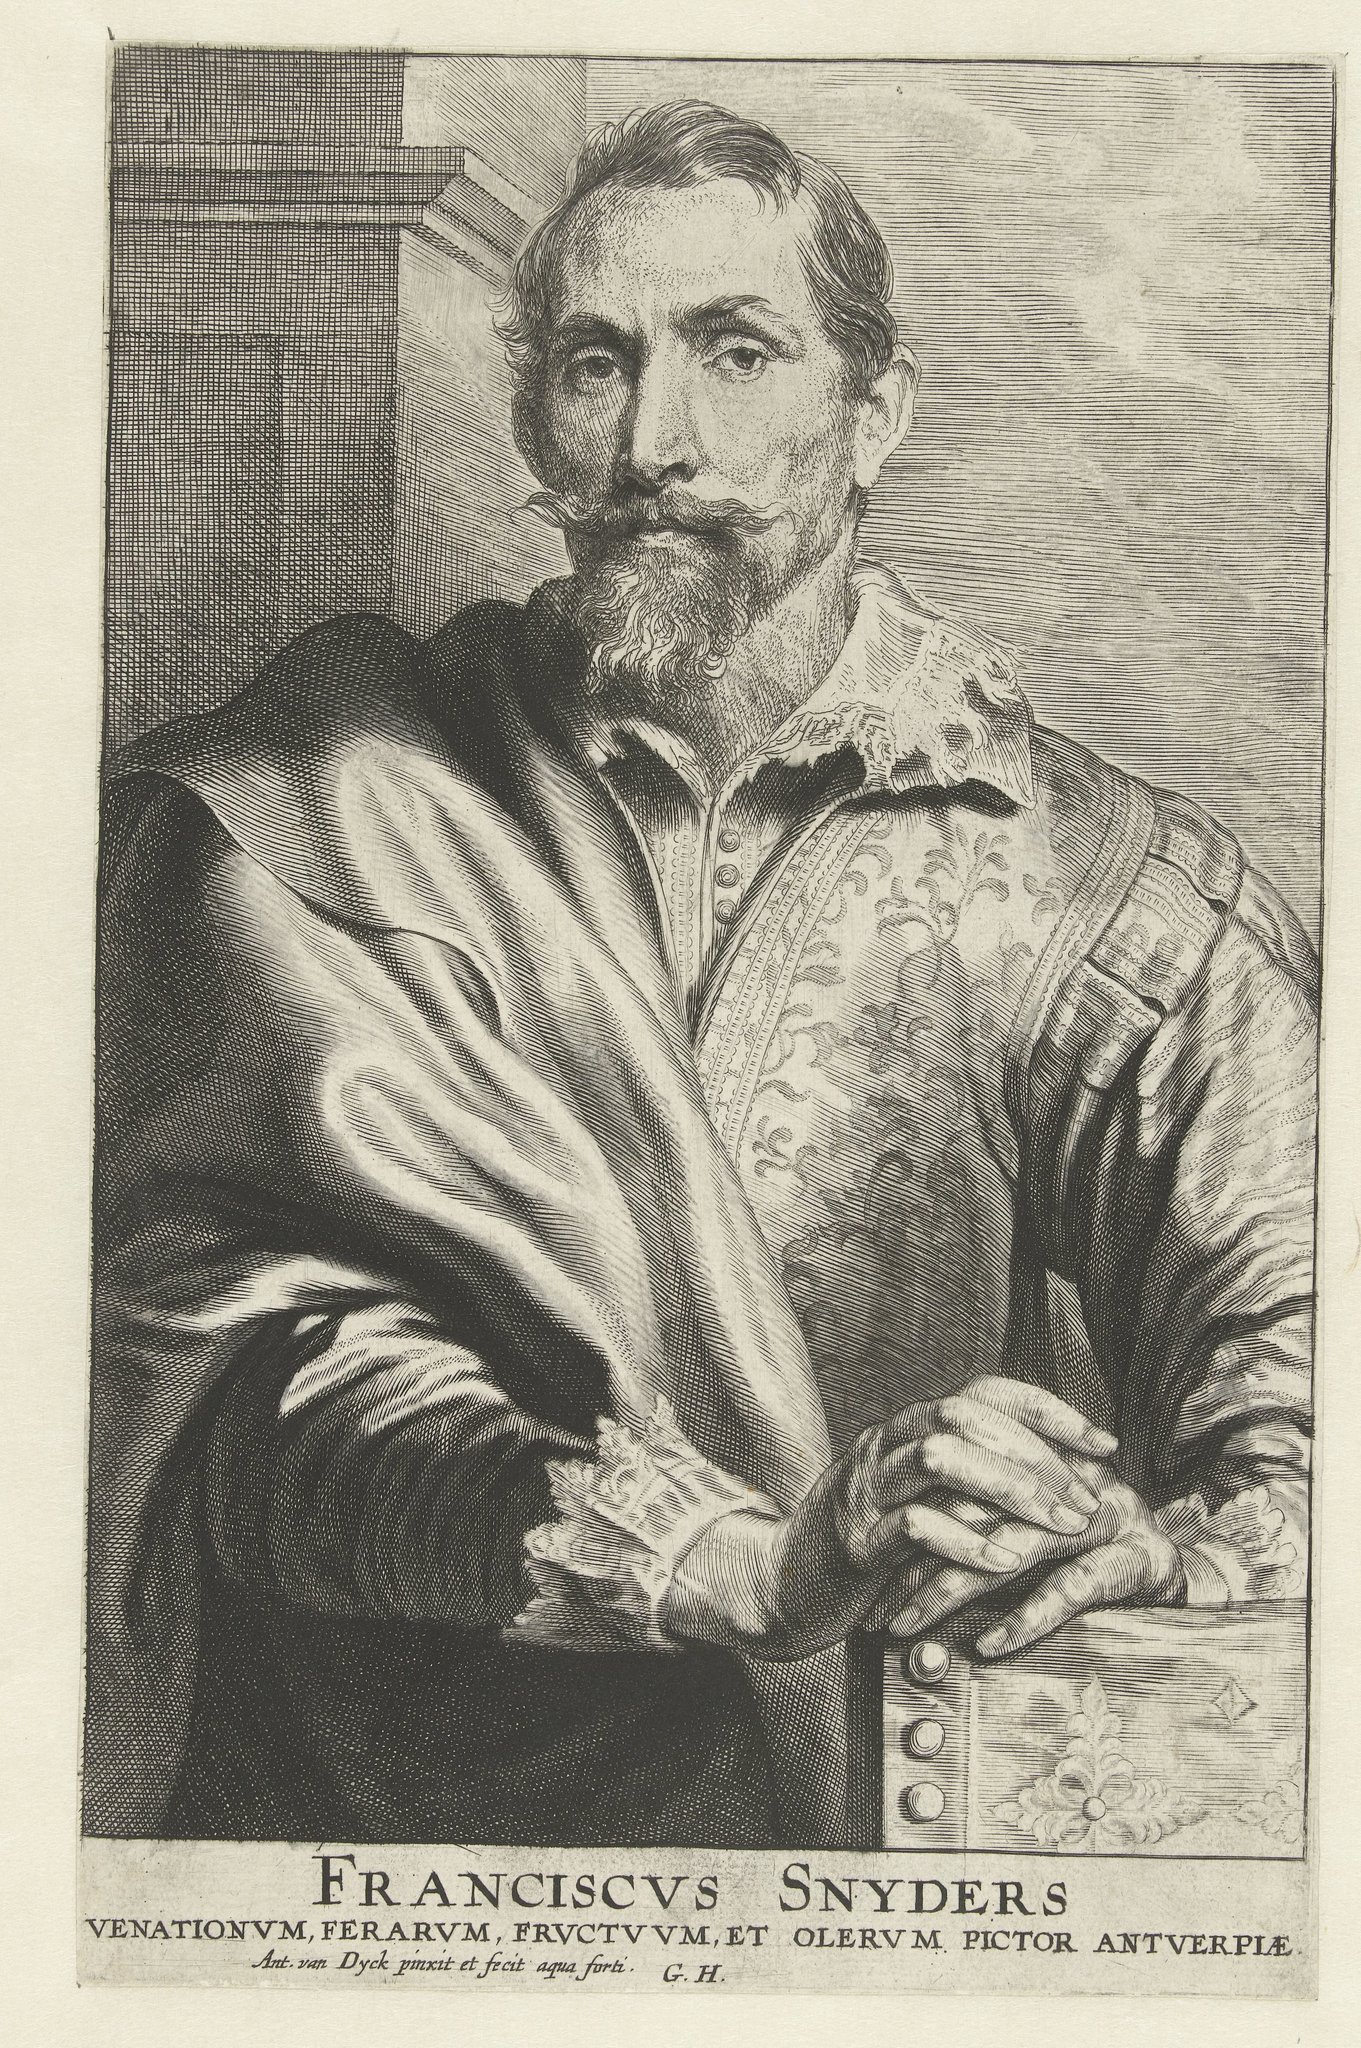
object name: print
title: Iconographie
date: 1630-1632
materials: paper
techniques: brush, engraving, etching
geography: low countries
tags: draughtsman, frans snijders, portrait, self-portrait of painter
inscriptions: collector's mark: Lugt 240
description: Portret van Frans Snijders met onderschrift FRANCISCVS SNYDERS VENATIONVM FERARVM, FRVCTVVM, ET OLERVM PICTOR ANTUERPIAE